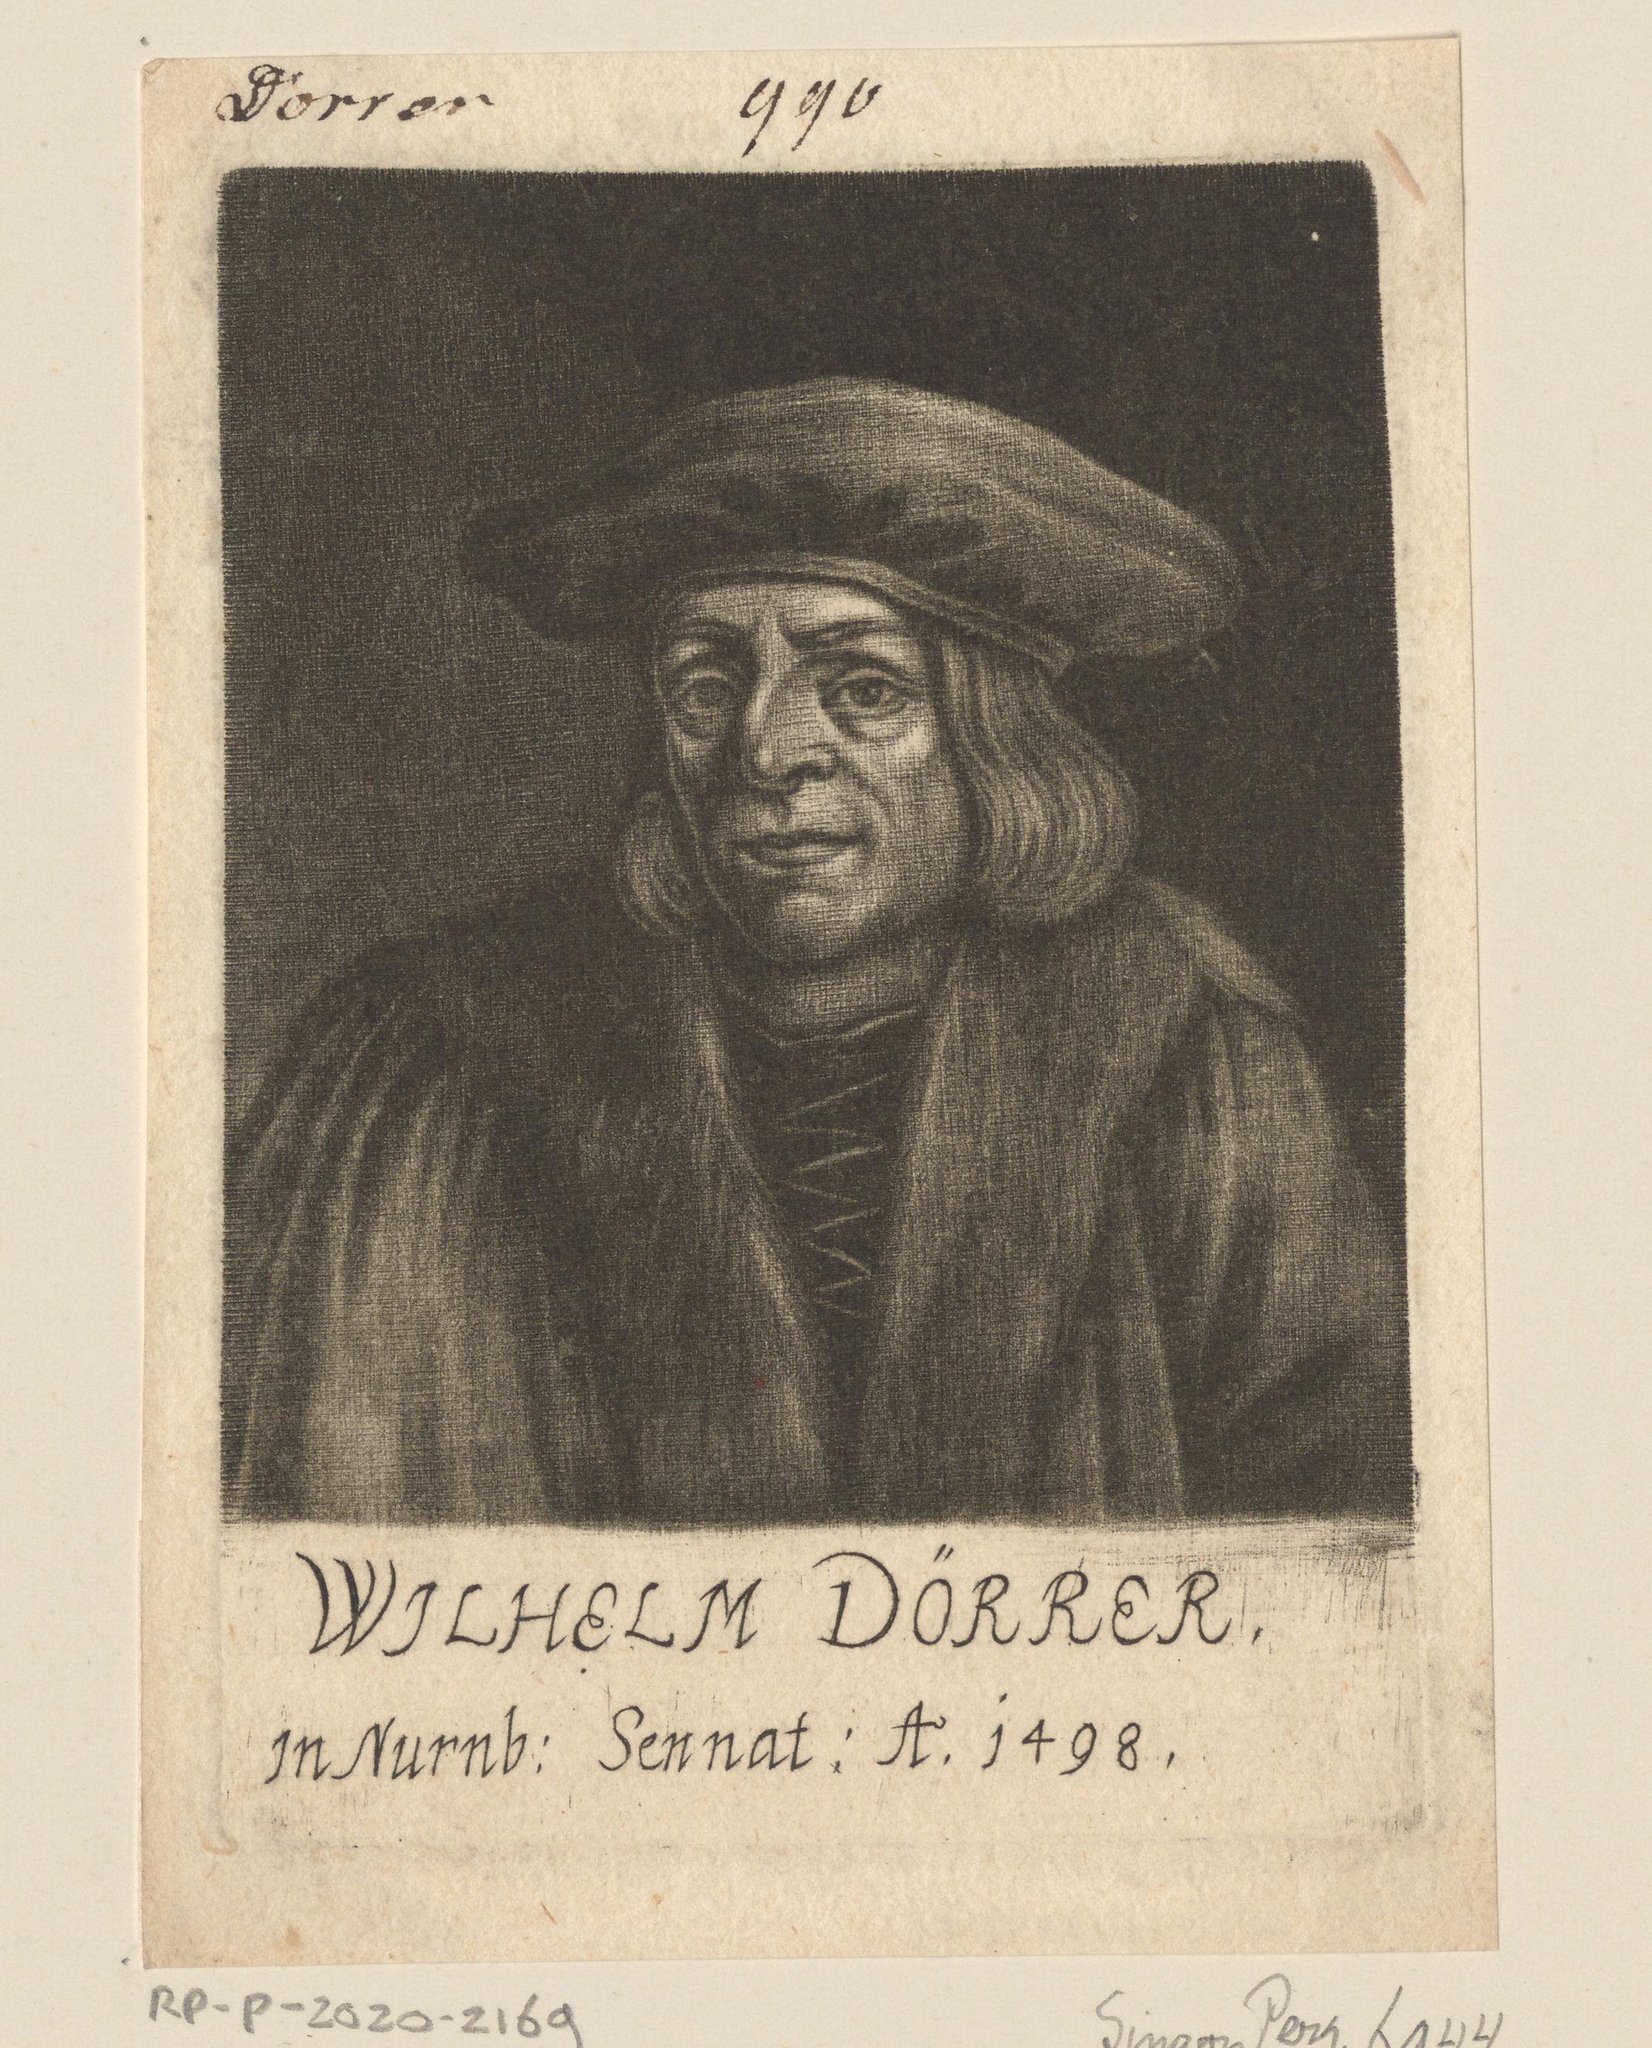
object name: print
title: Portret van Wilhelm Dörrer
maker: georg fennitzer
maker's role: print maker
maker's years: 1646-1722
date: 1656-1722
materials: paper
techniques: engraving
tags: historical persons